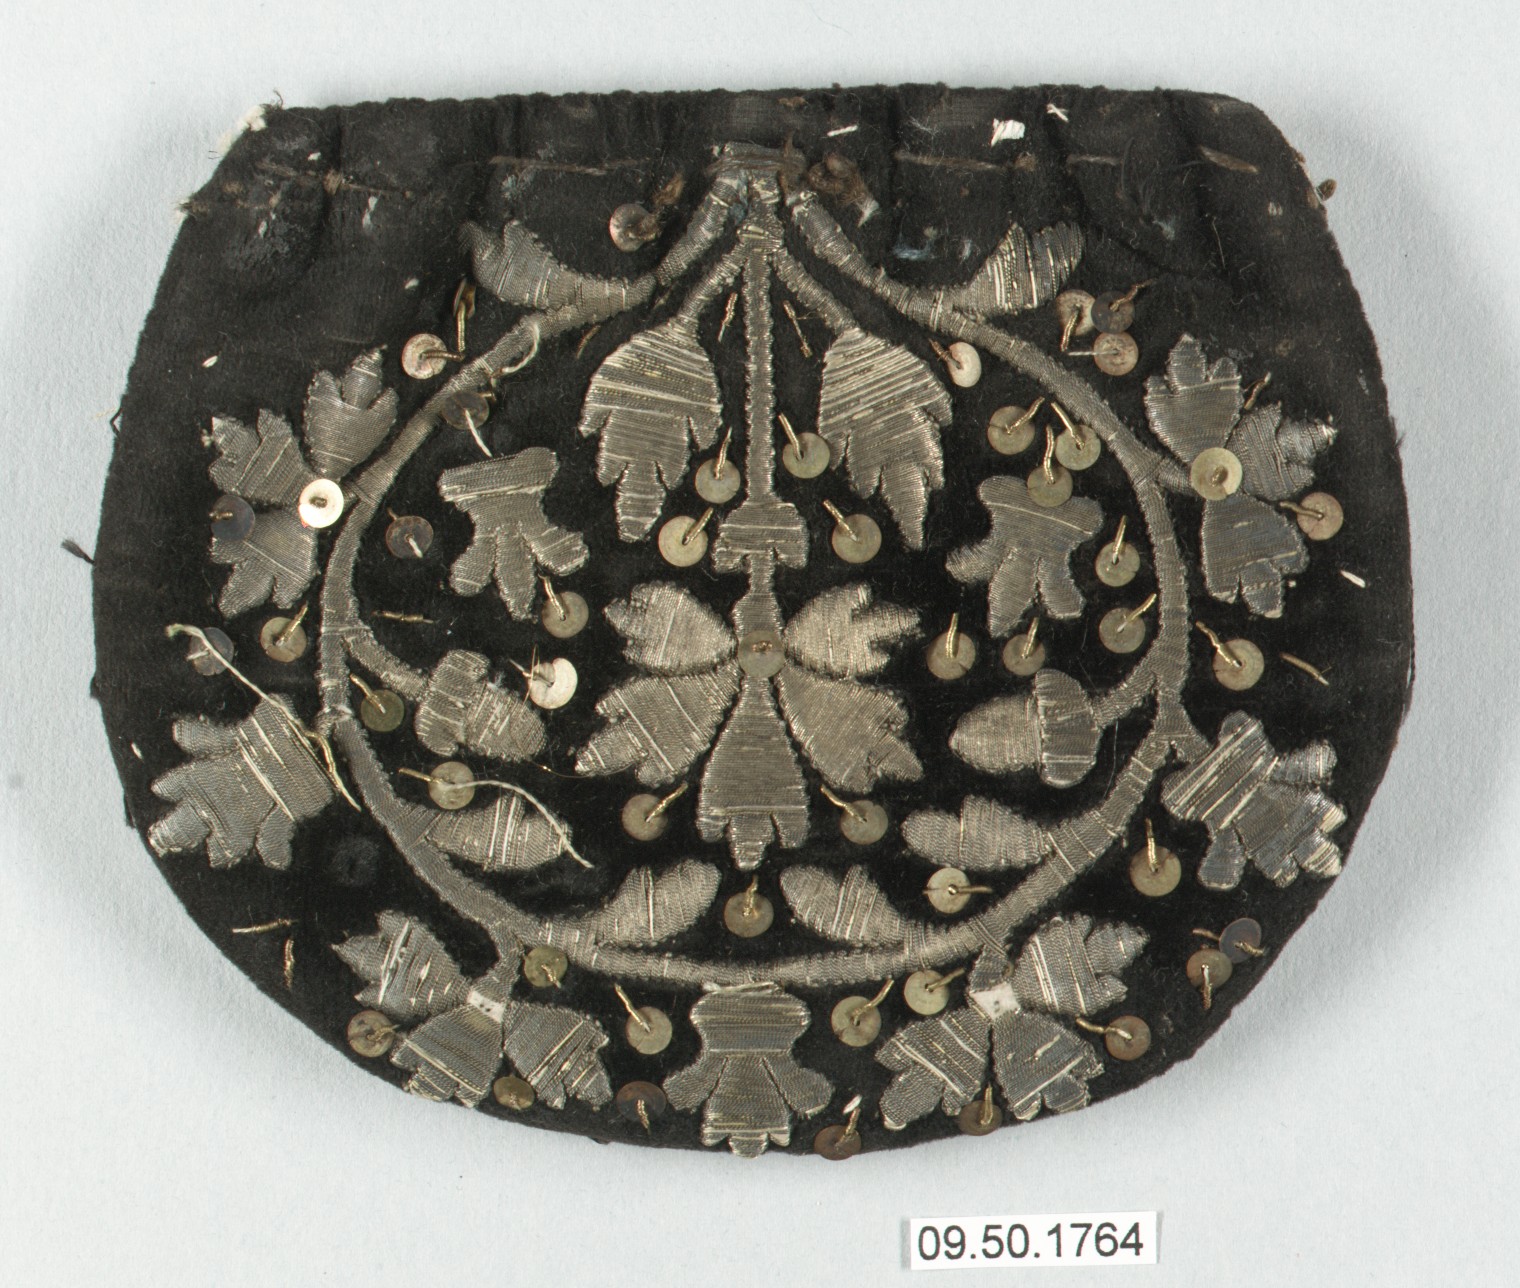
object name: cap crown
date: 1801-1900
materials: metal thread, velvet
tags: flowers